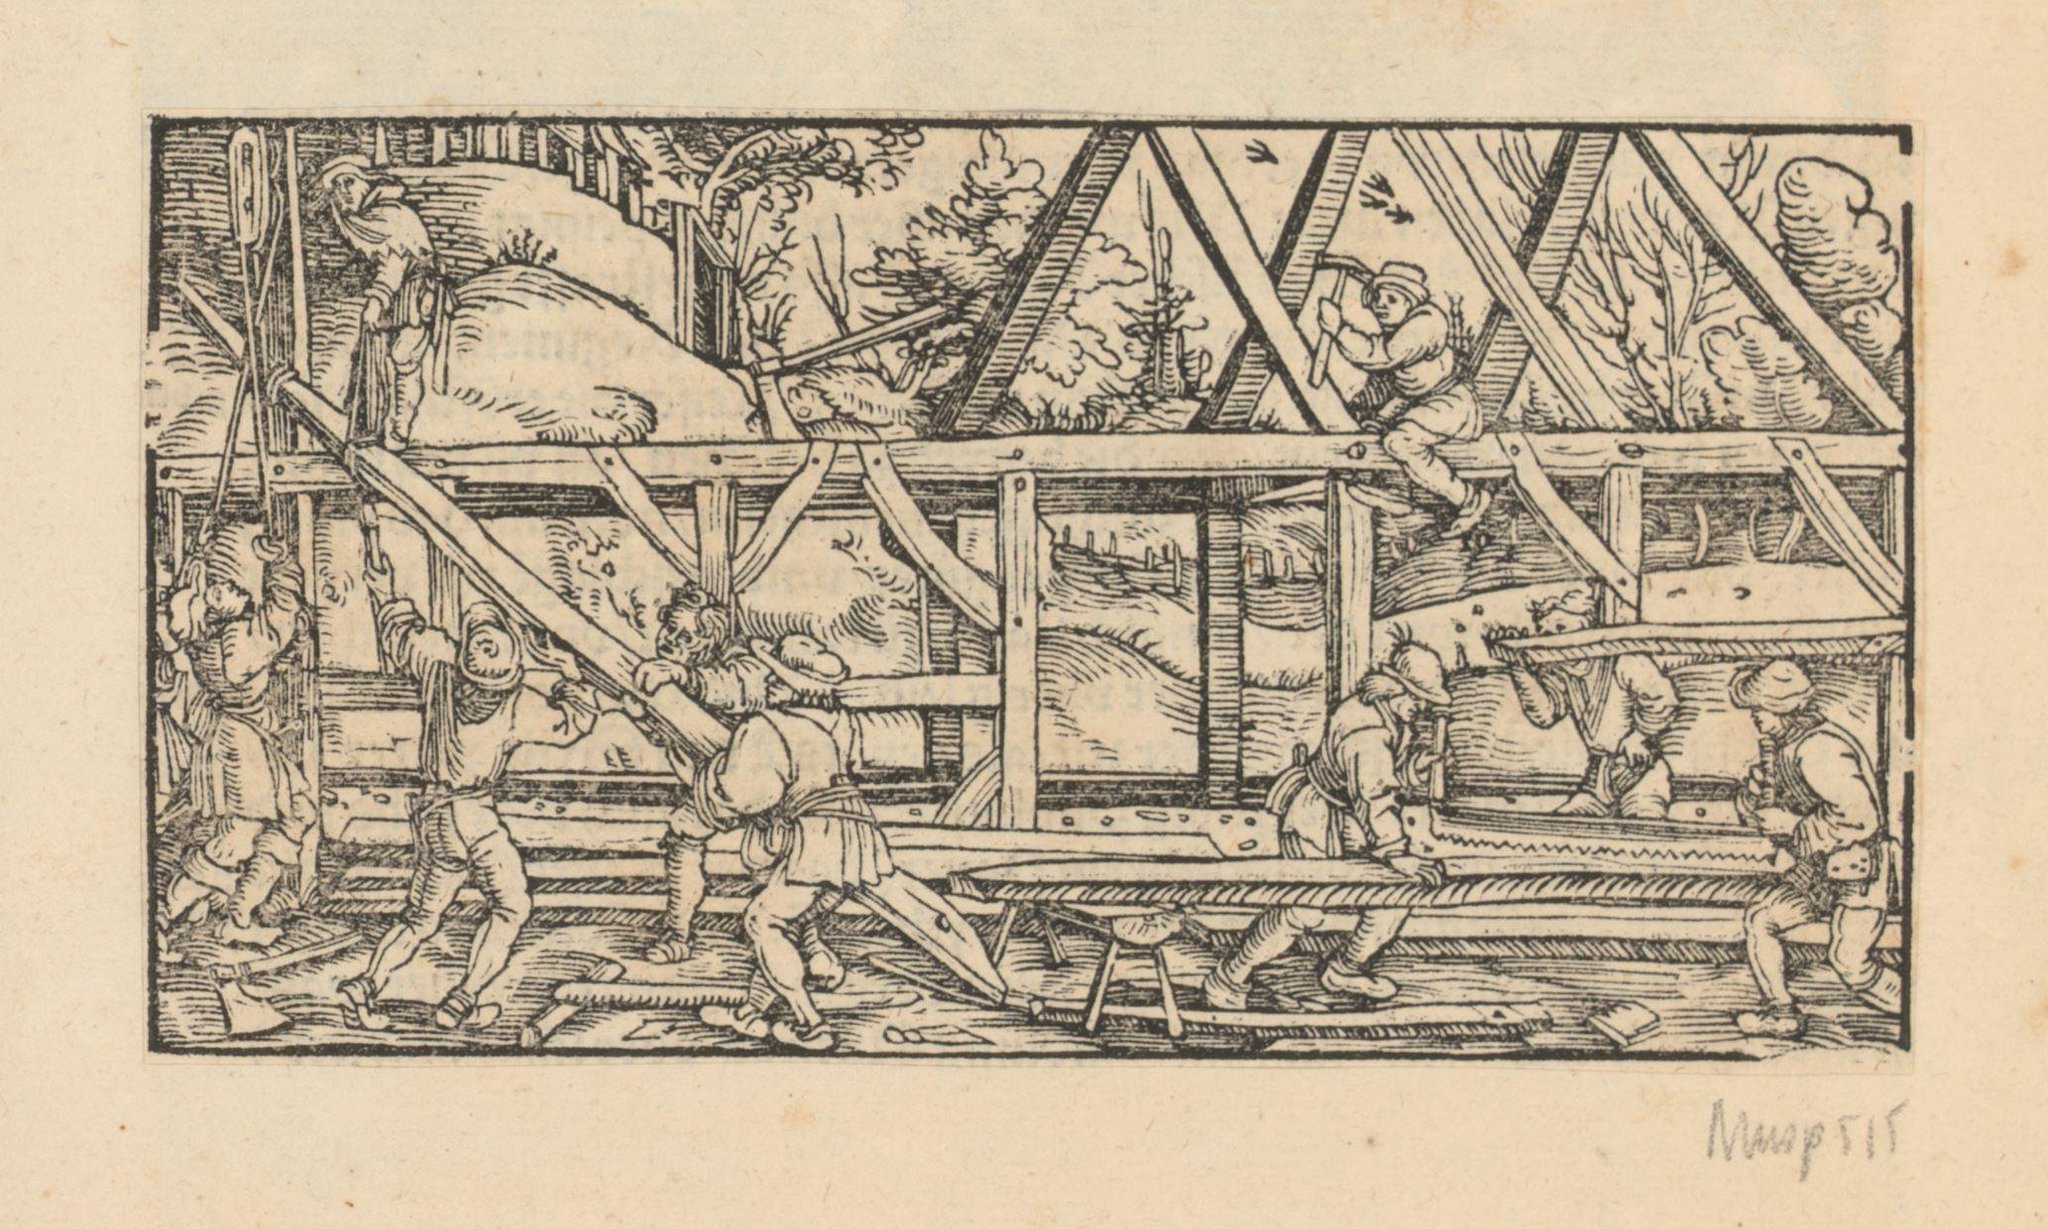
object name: book illustration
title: Timmermannen bouwen een huis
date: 1514-1531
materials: paper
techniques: letterpress printing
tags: carpenter, timber framing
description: Deze prent is gebruikt in: Cicero, Marcus Tulius. Officia M.T.C. Ein Buch so Marcus Tullius Cicero der Römer zu seynem (...). [Vertaald uit het Latijn door] Johann von Schwarzenberg. Augsburg: Heinrich Steiner, 1531.